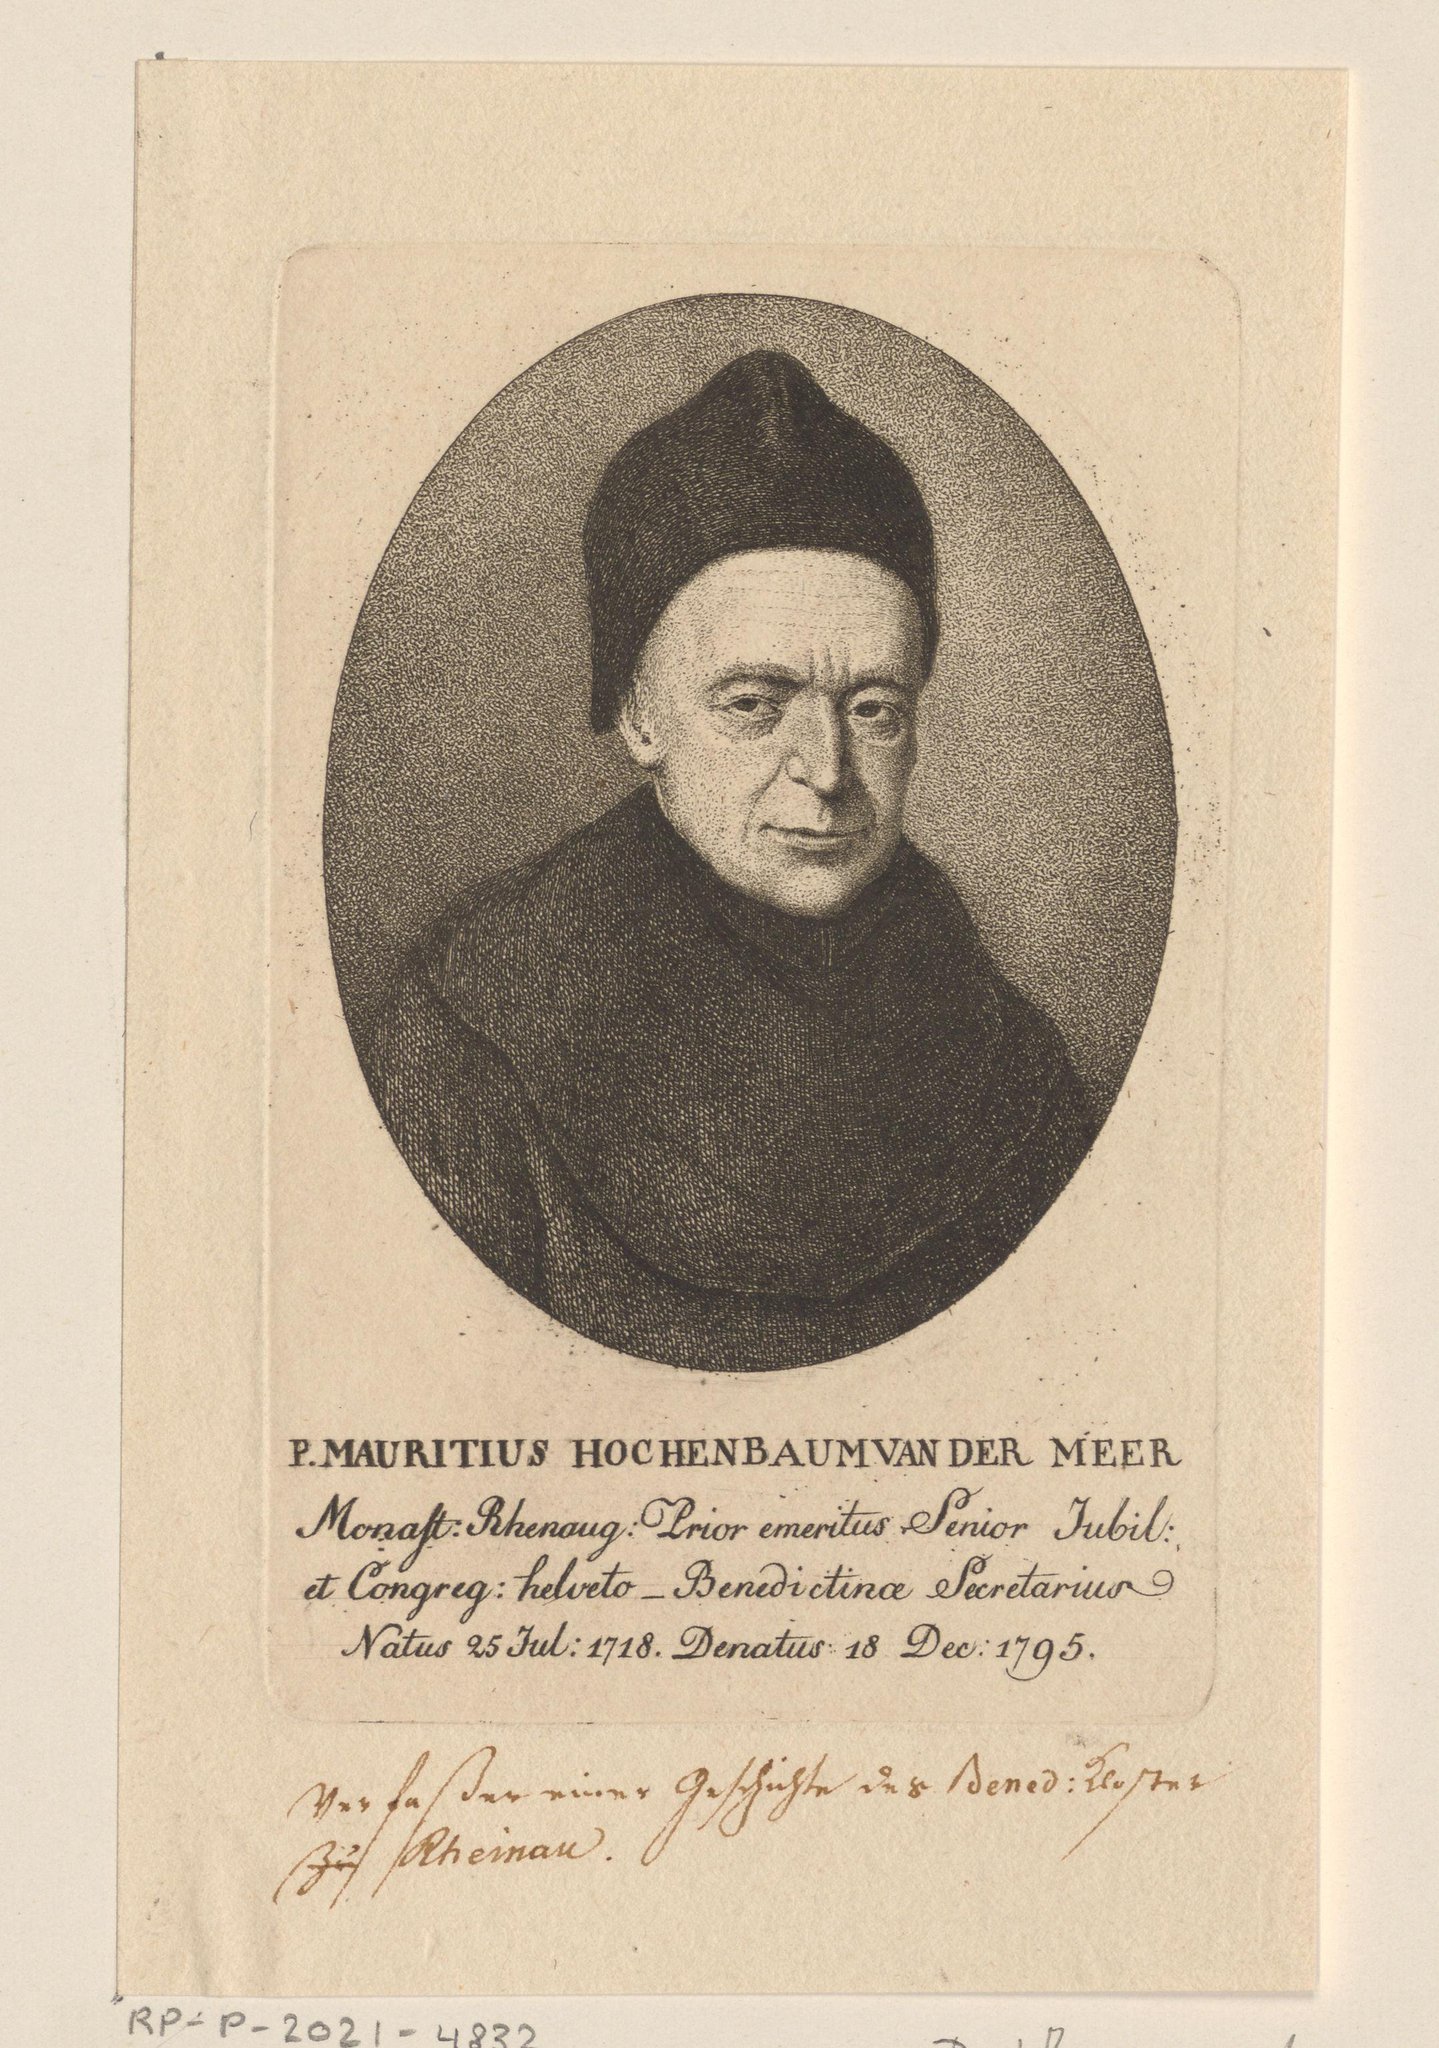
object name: print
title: Portret van Moritz Hohenbaum van der Meer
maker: Anonymous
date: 1795-1825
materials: paper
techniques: engraving, etching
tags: historical persons, portrait of a writer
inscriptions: inscription: ‘[...] Rheinau’